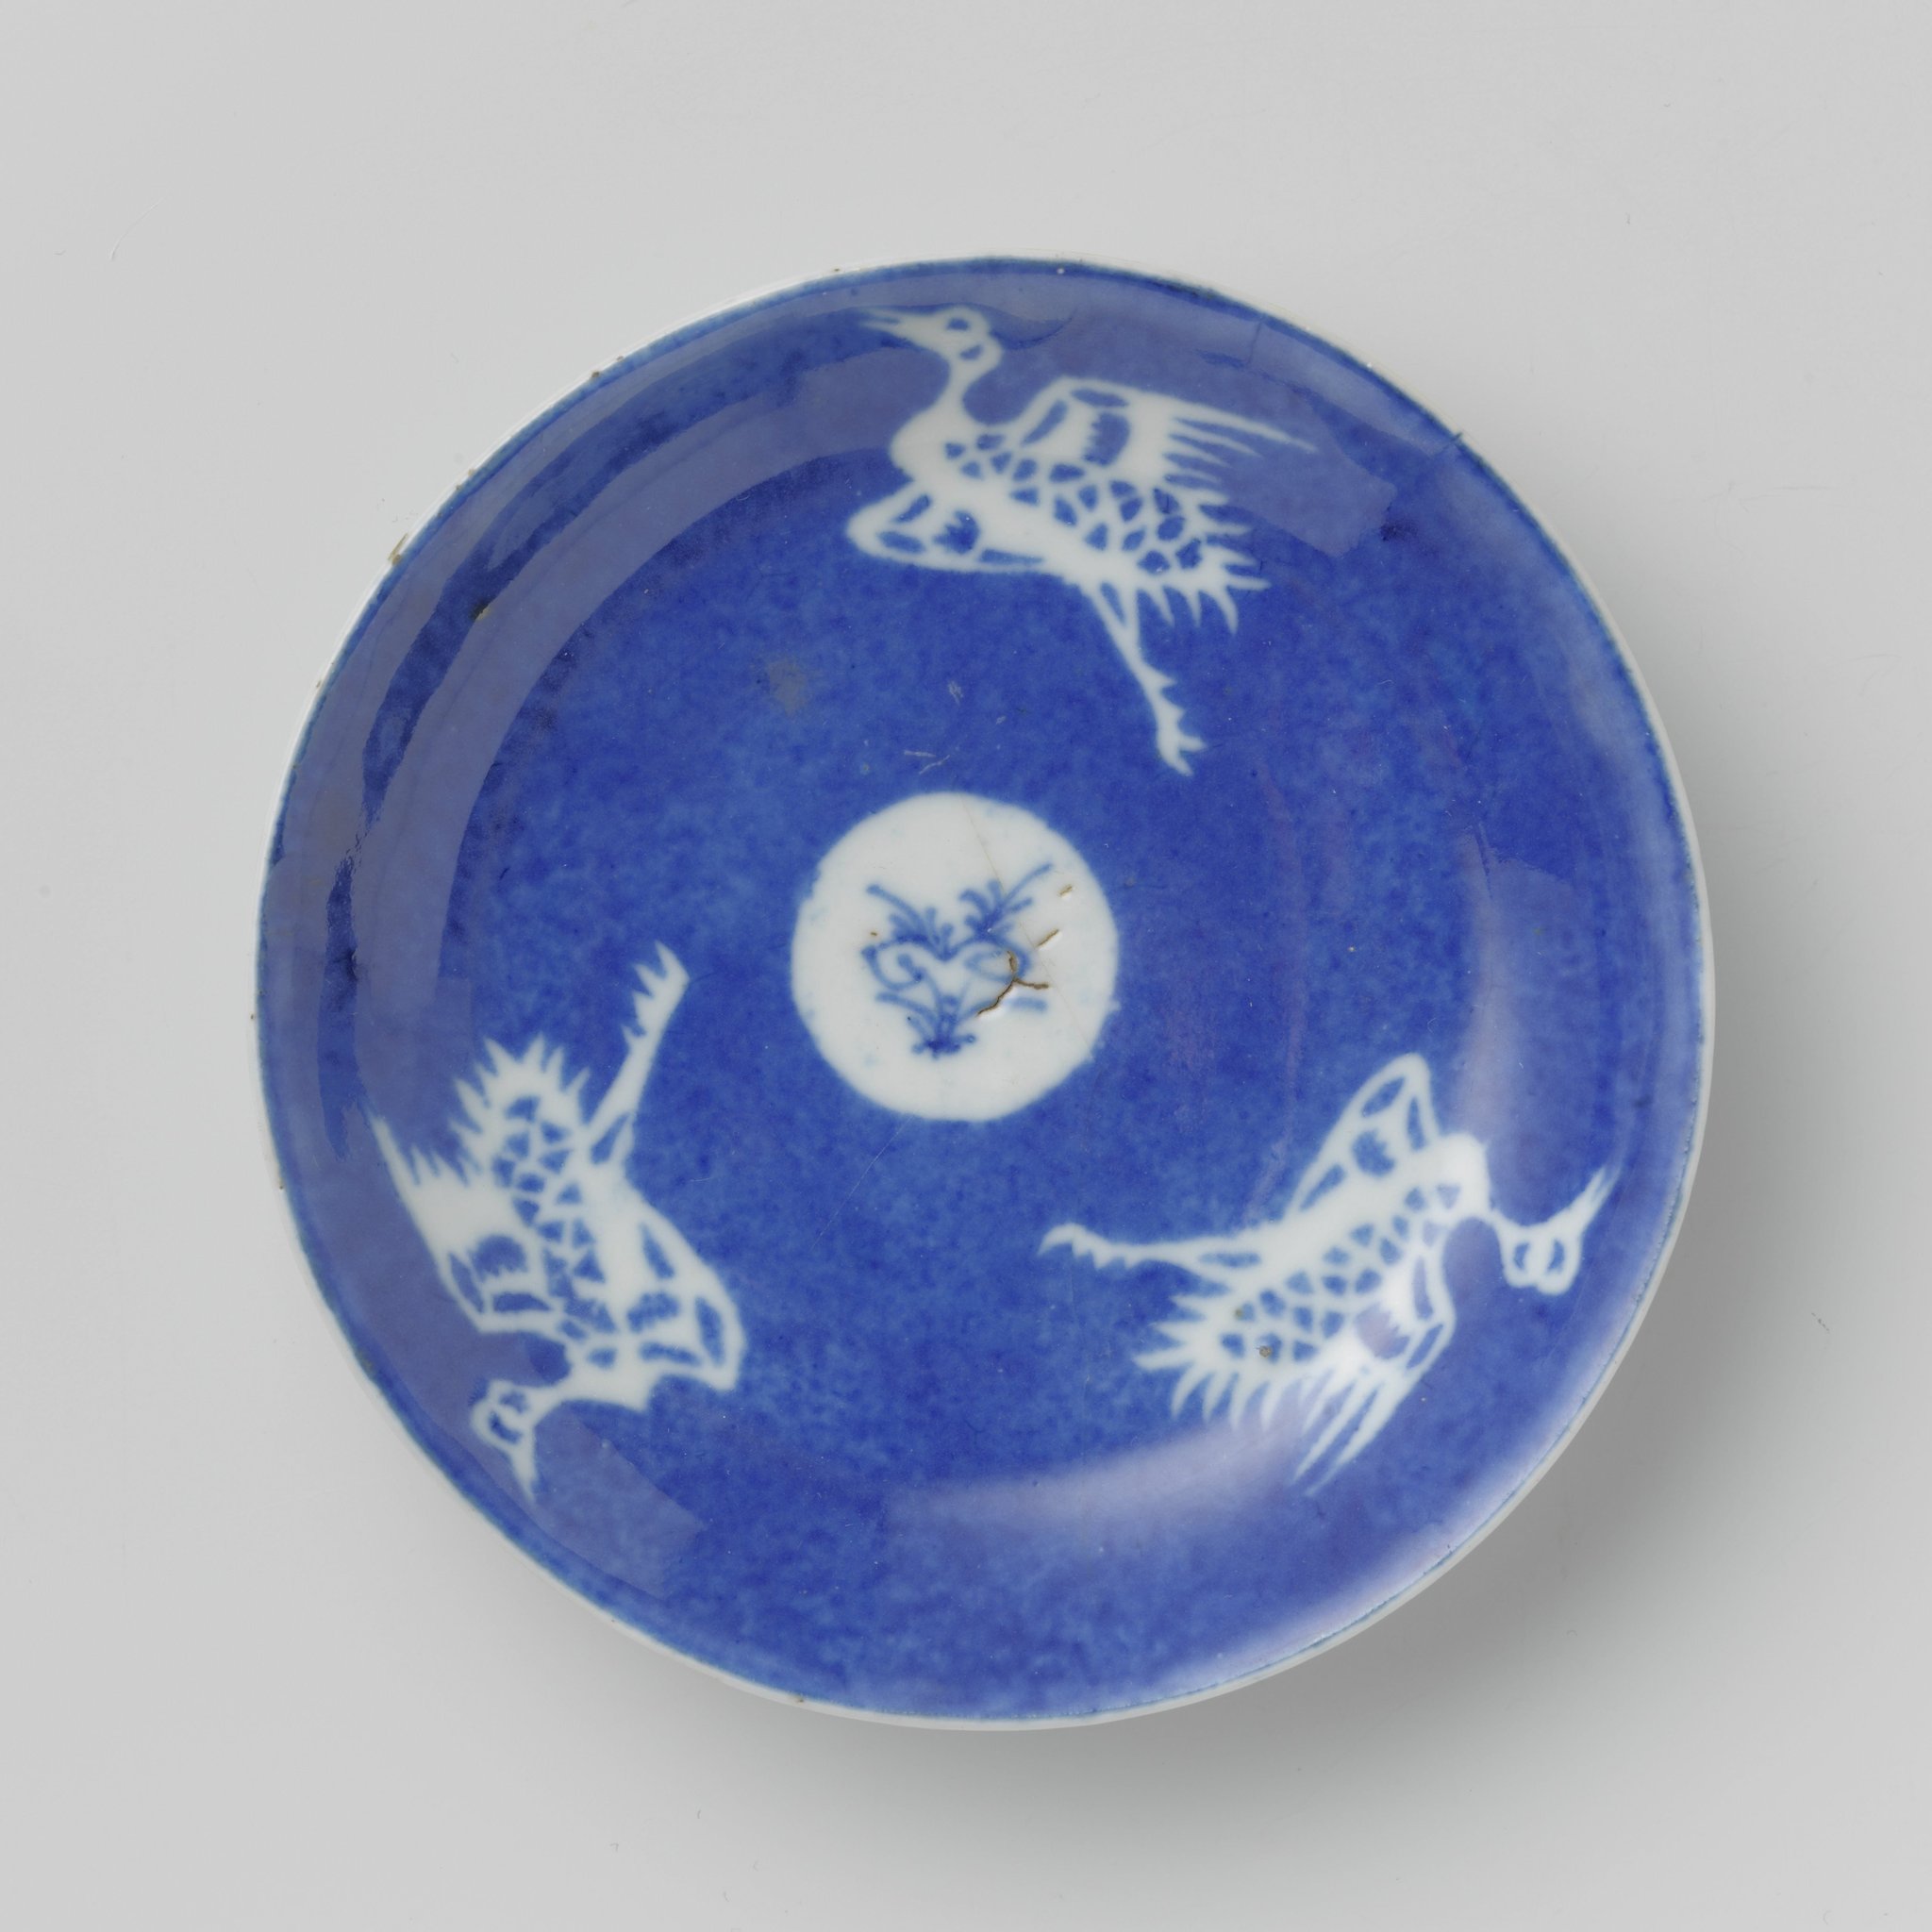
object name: platter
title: Saucer with powder blue and cranes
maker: Anonymous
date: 1700-1724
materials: cobalt, glaze, paint, porcelain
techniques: firing, turning, vitrification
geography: china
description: Schotel van porselein, beschilderd in onderglazuur blauw. Met bijbehorende theekop (AK-RBK-15855-B-1). Bleu poudré.